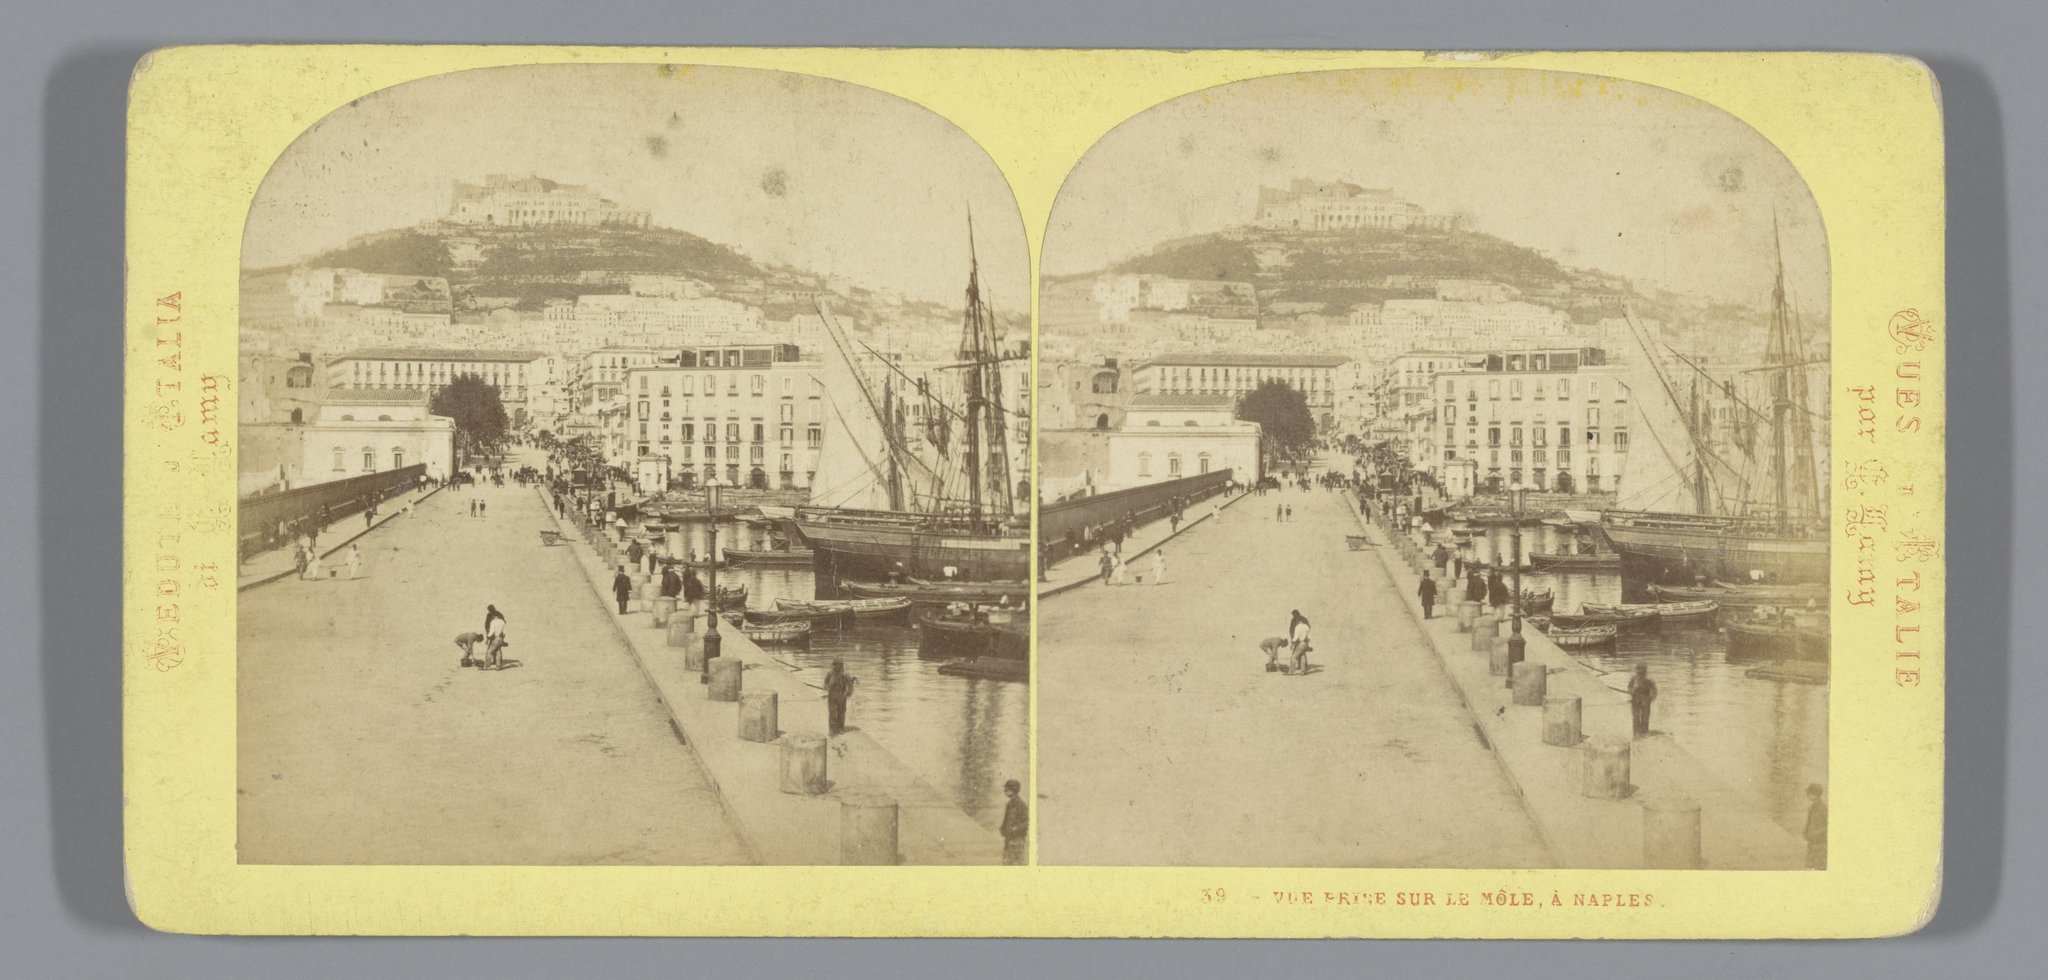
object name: stereograph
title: Vedute d'Italia / Vues d'Italie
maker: ernest eléonor pierre lamy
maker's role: publisher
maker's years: 1828-1900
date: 1861-1878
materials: cardboard, paper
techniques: albumen print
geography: naples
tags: pier, quay, wharf, public road (+ city(-scape) with figures, staffage), naples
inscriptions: number: ‘39.’